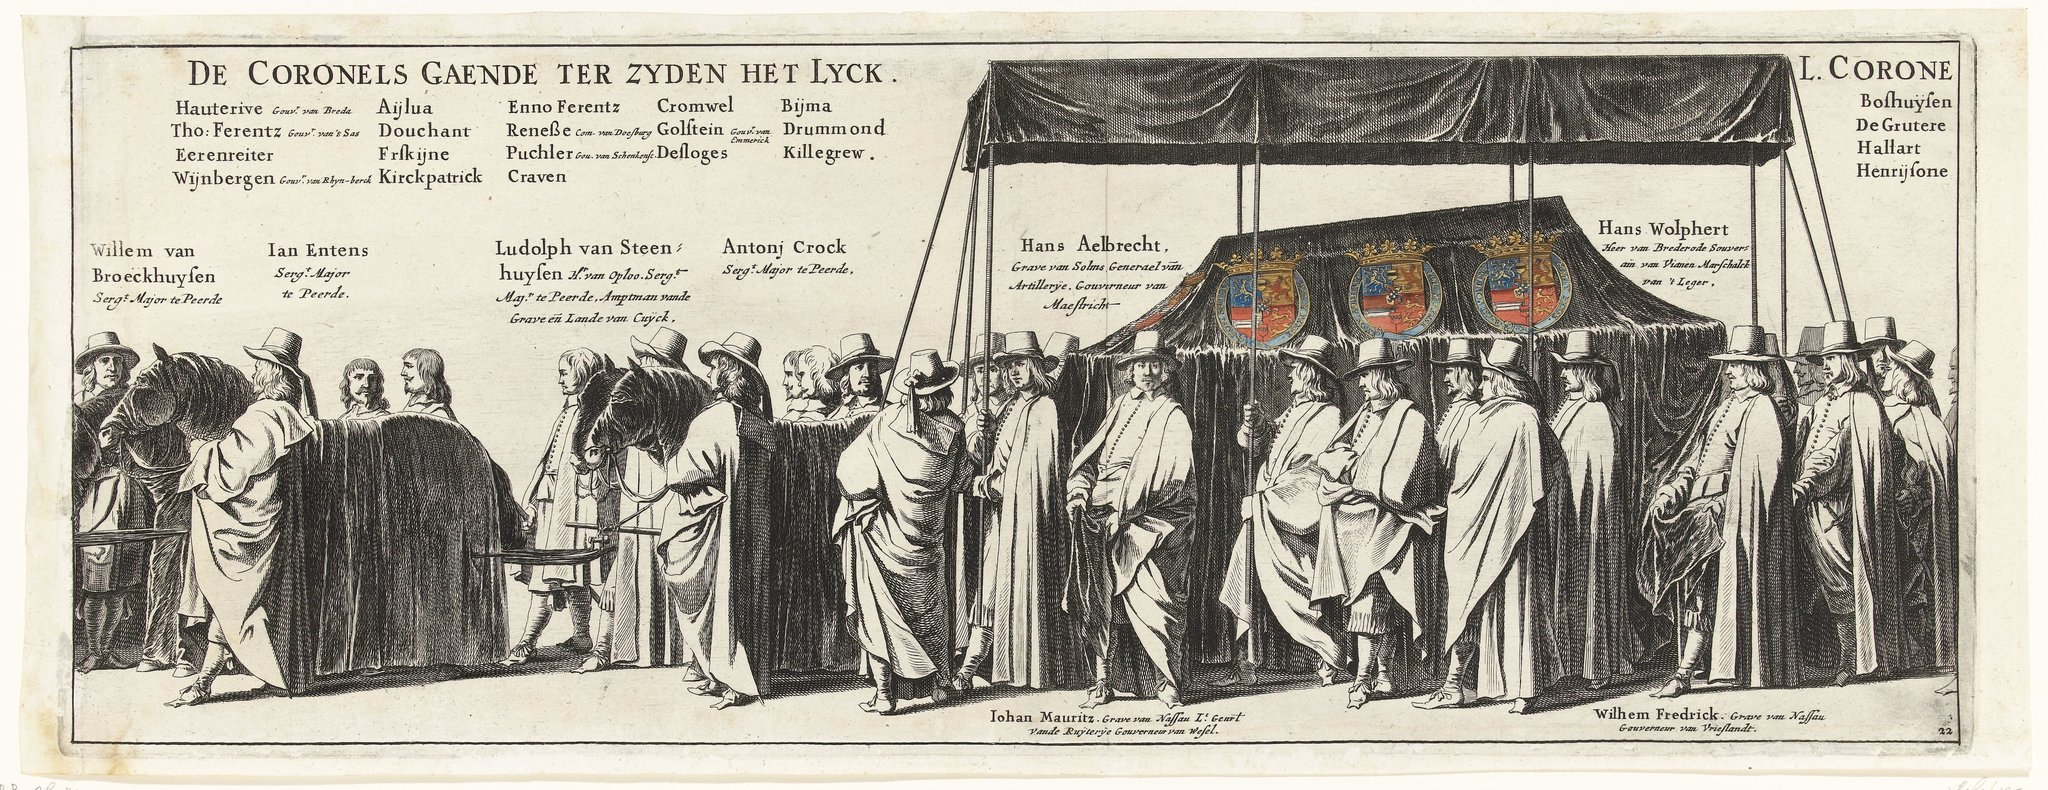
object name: print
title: De begrafenisstoet van Frederik Hendrik (plaat nr. 22), 1647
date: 1647-1651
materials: paper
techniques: etching, hand coloring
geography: the hague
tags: delft, the hague, frederick henry (prince of orange), cortege, funeral procession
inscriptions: collector's mark: Lugt 2228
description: De begrafenisstoet van stadhouder Frederik Hendrik te 's-Gravenhage op 10 mei 1647. Plaat nr. 22 met een deel van de stoet met de lijkwagen, boven de personen staan hun naam en functie. Onderdeel van een serie van 30 platen en 20 tekstbladen, bedoeld om aan elkaar geplakt te worden.